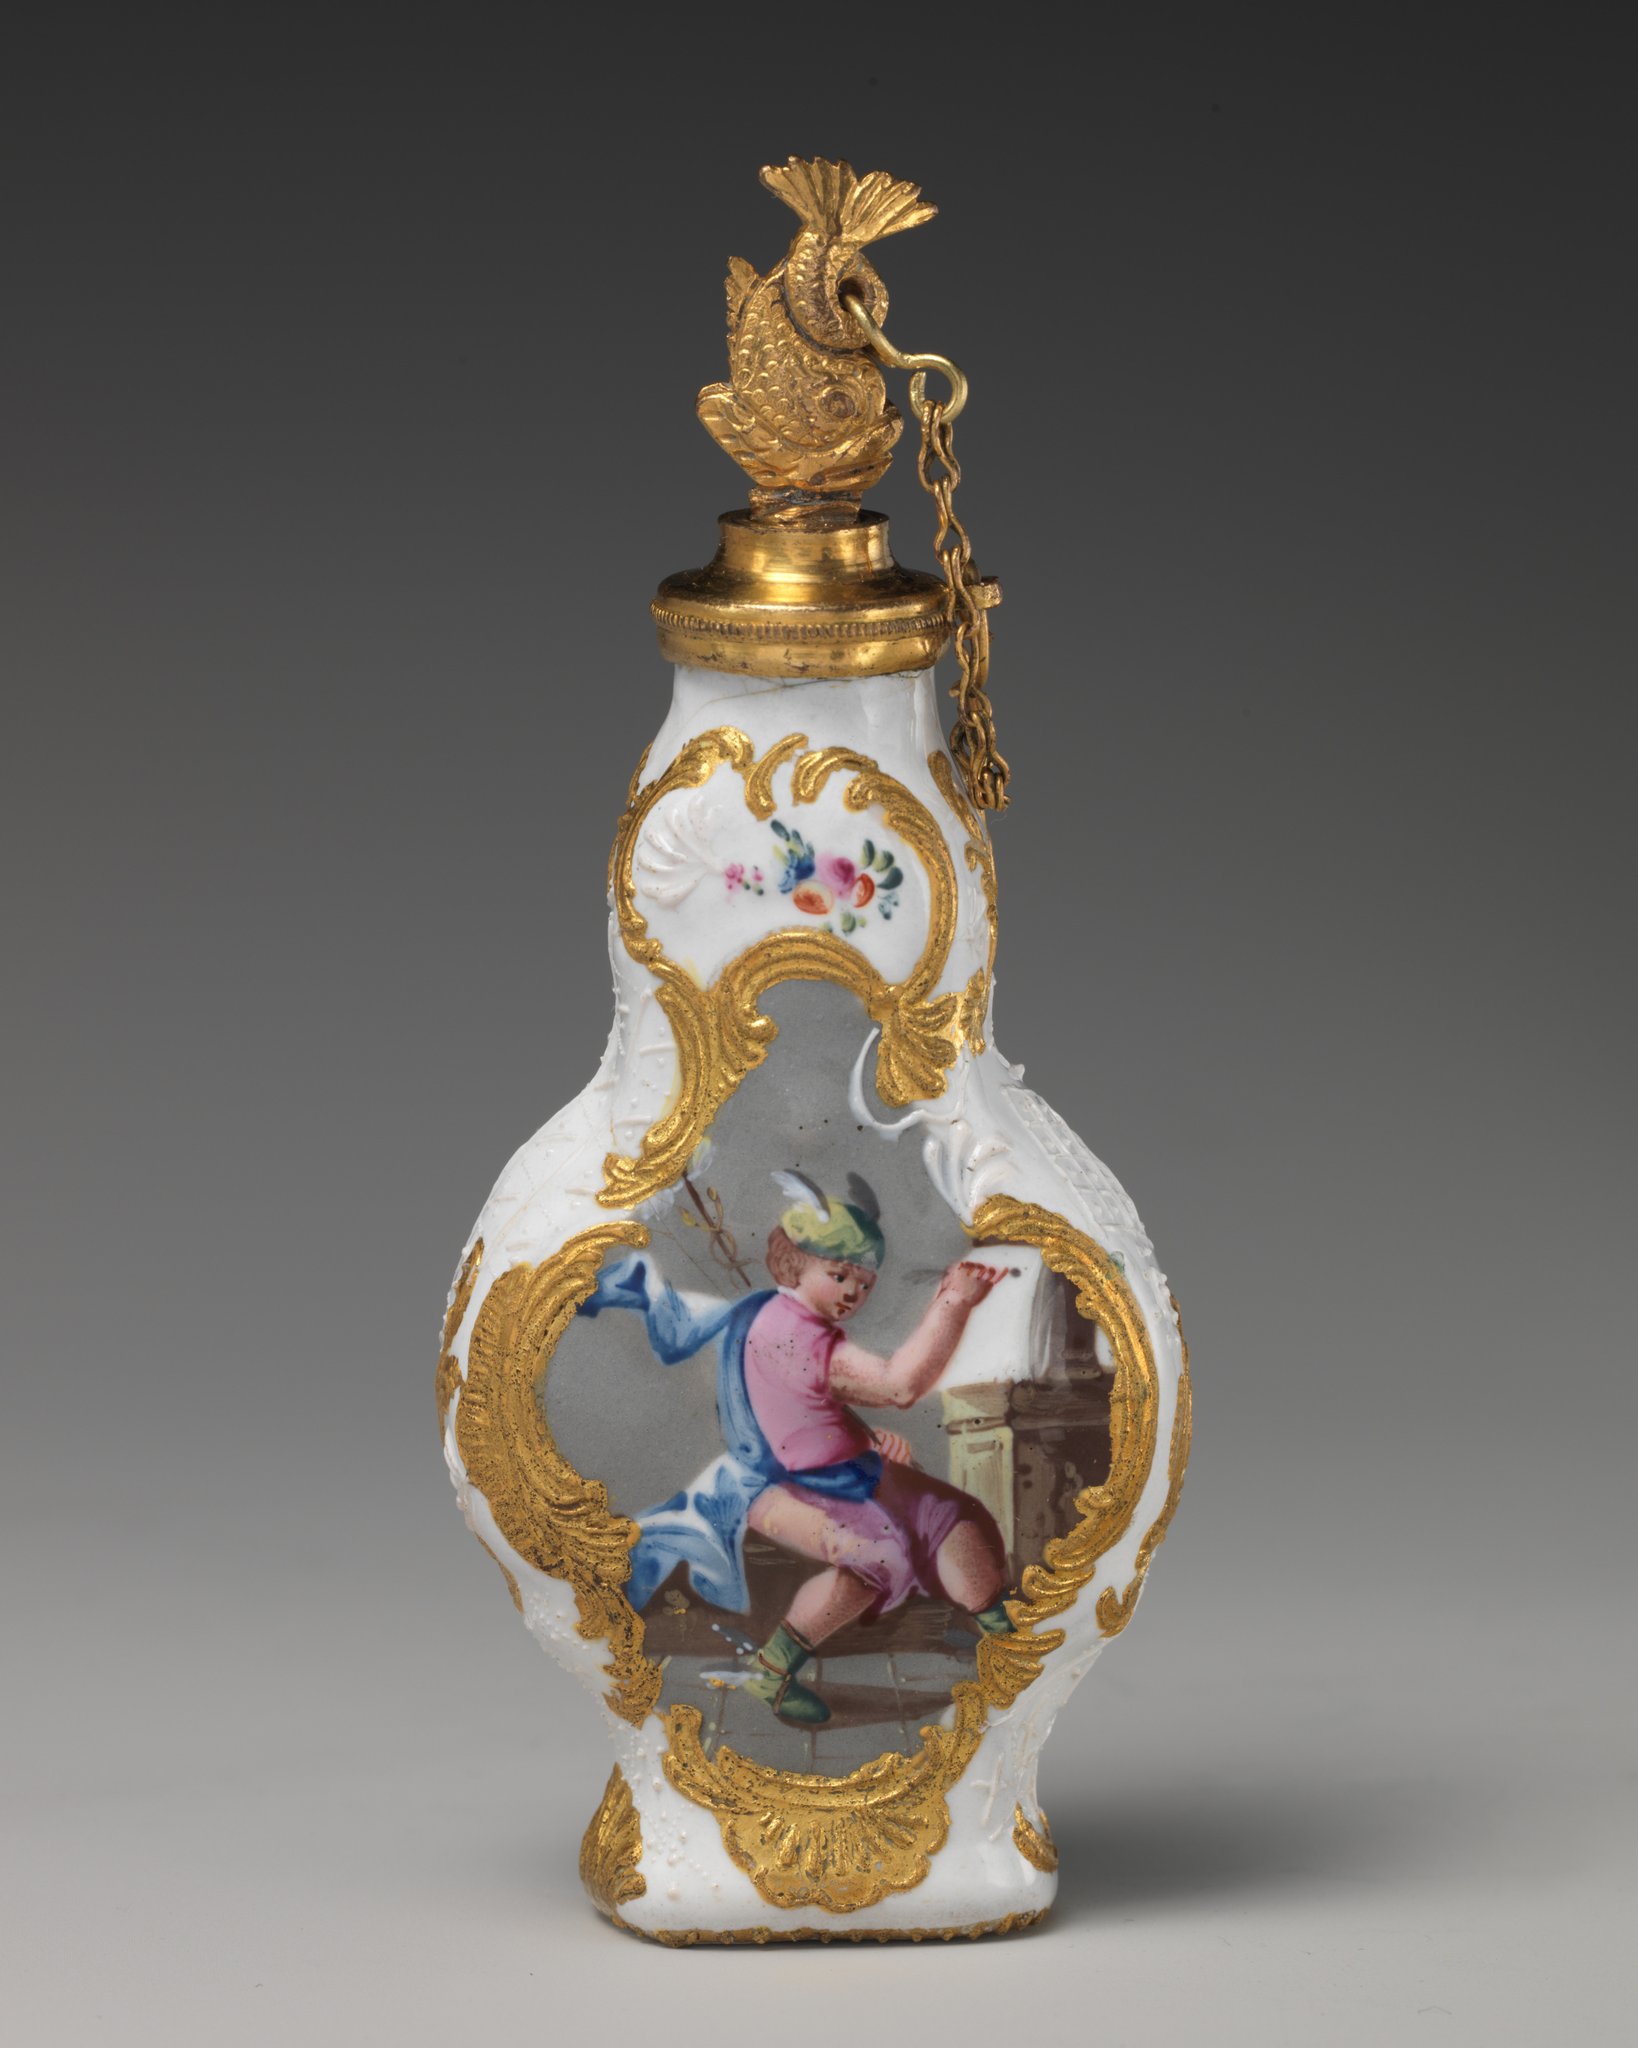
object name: scent bottle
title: Scent bottle with Minerva and Mercury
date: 1765-1770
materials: copper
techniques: enamel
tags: women,owls